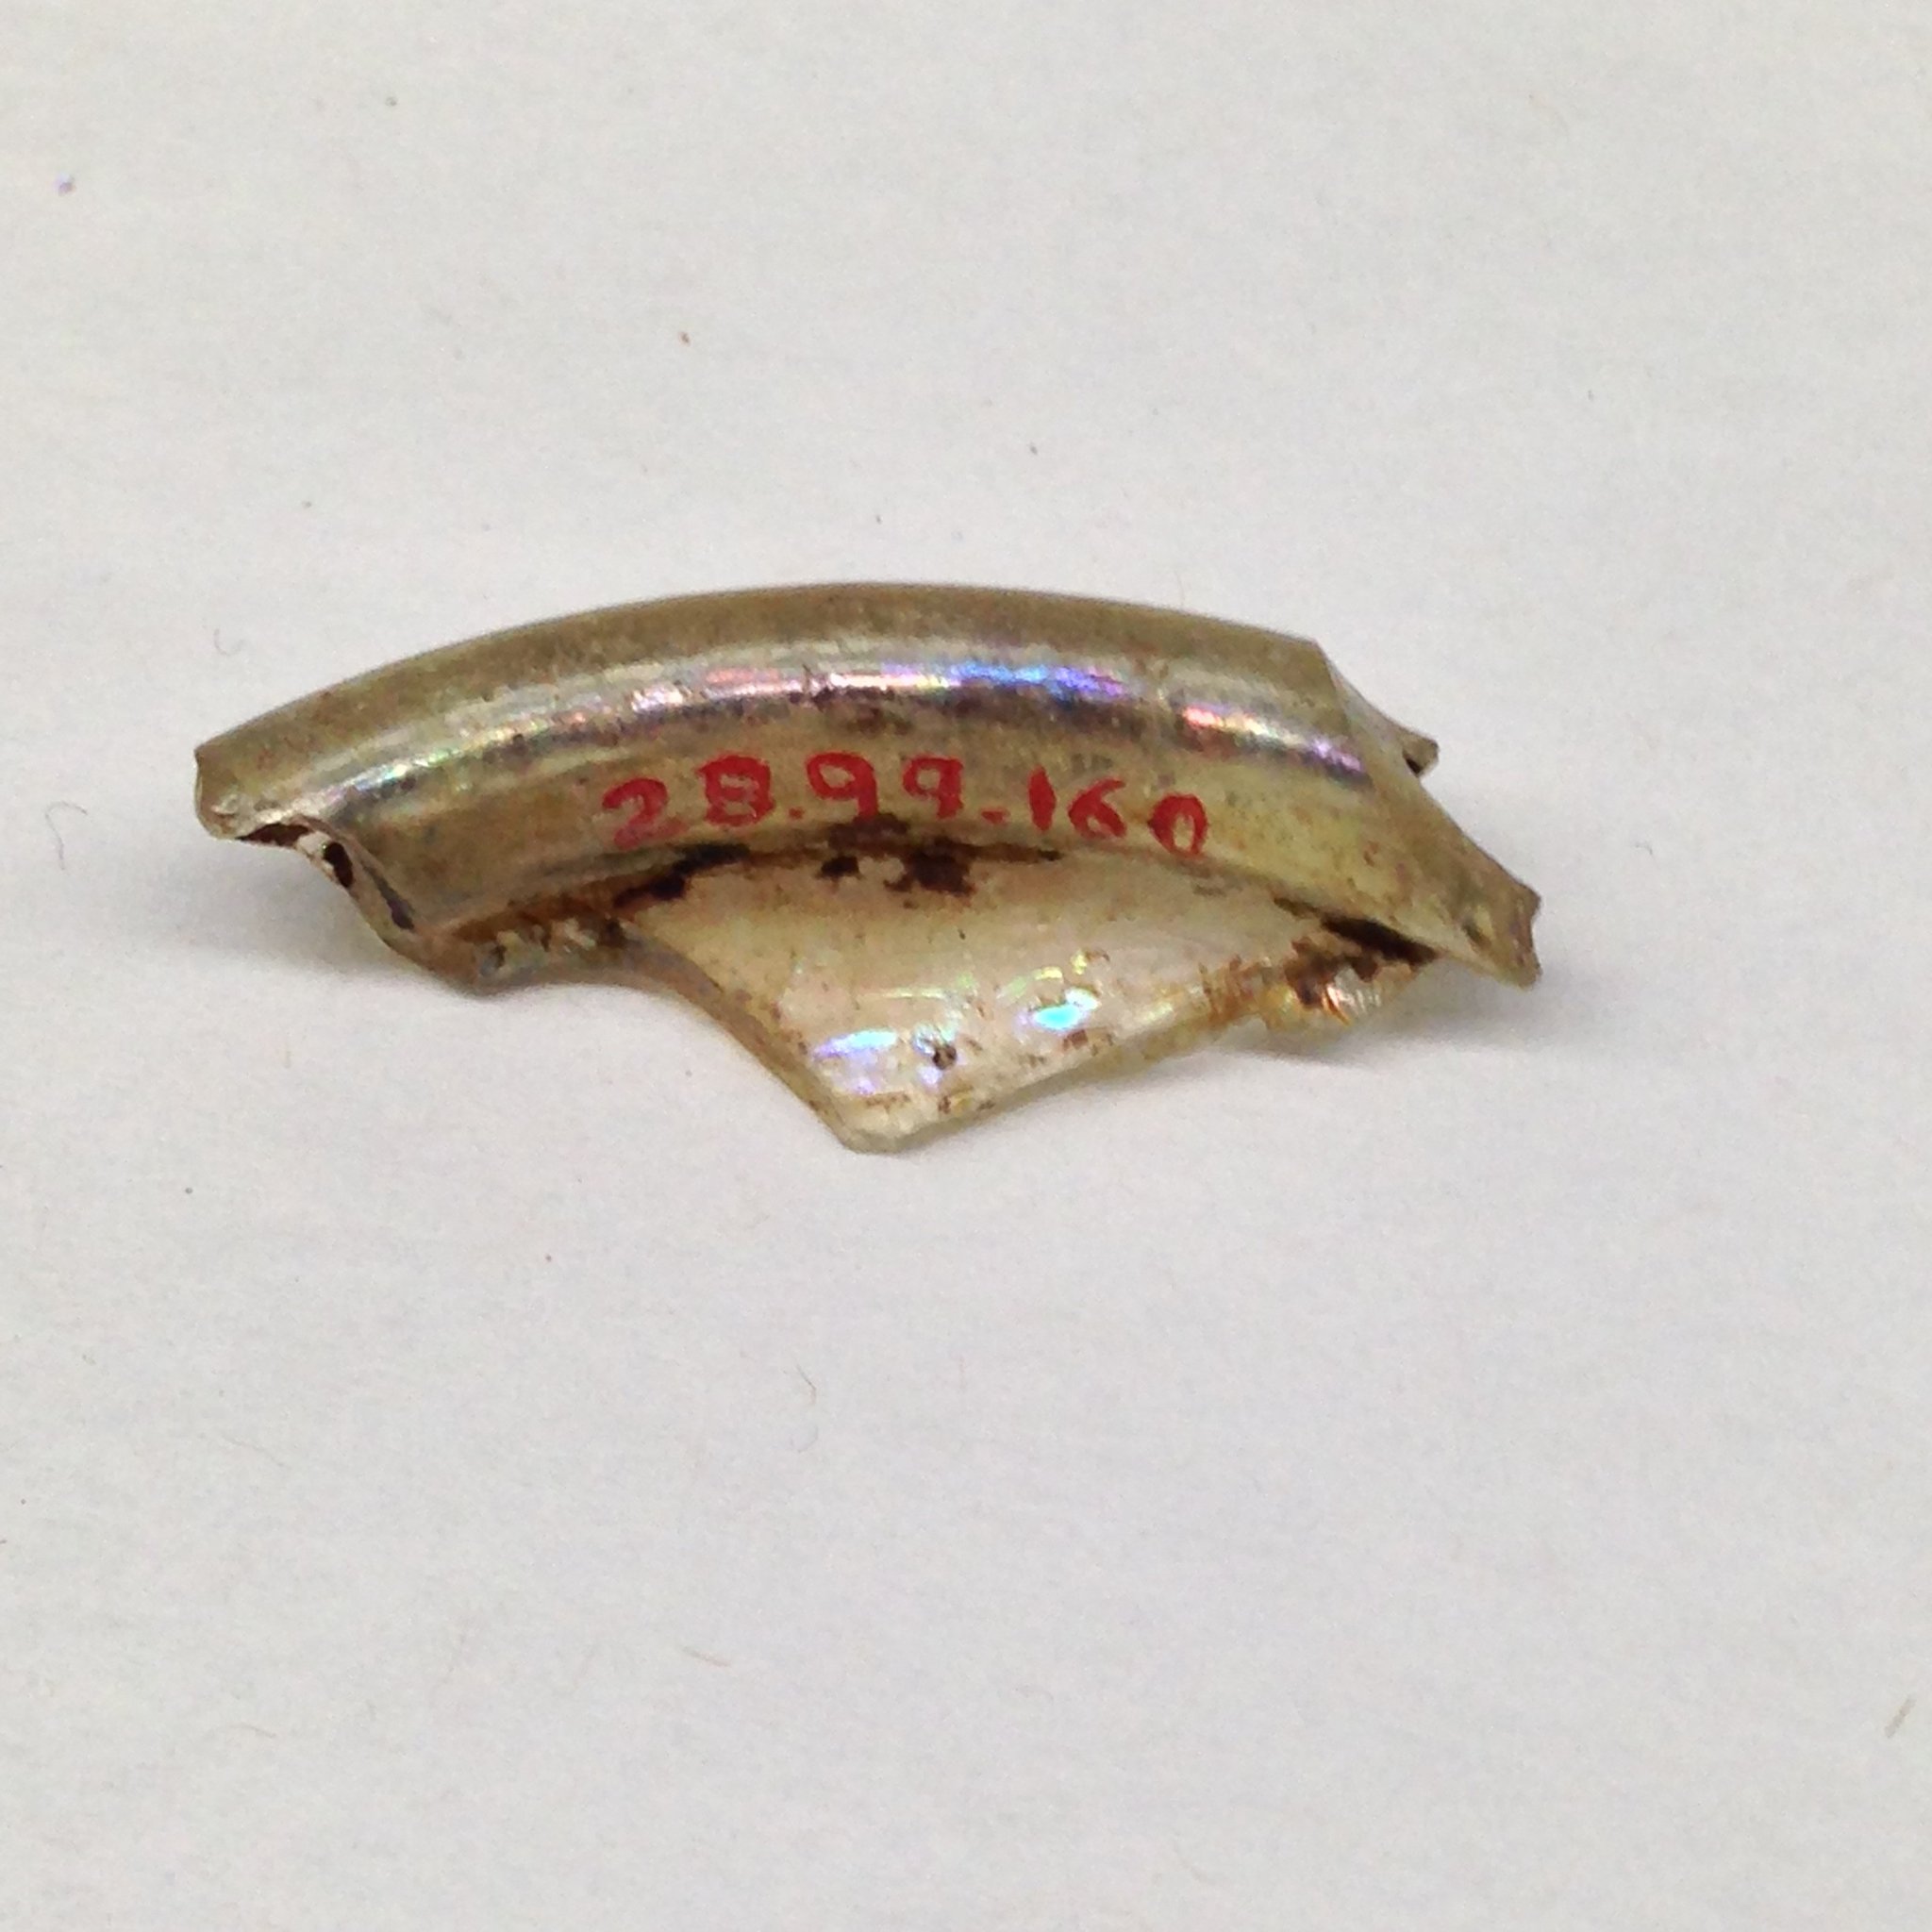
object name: fragment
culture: european or middle eastern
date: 1150-1250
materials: ceramic, glass